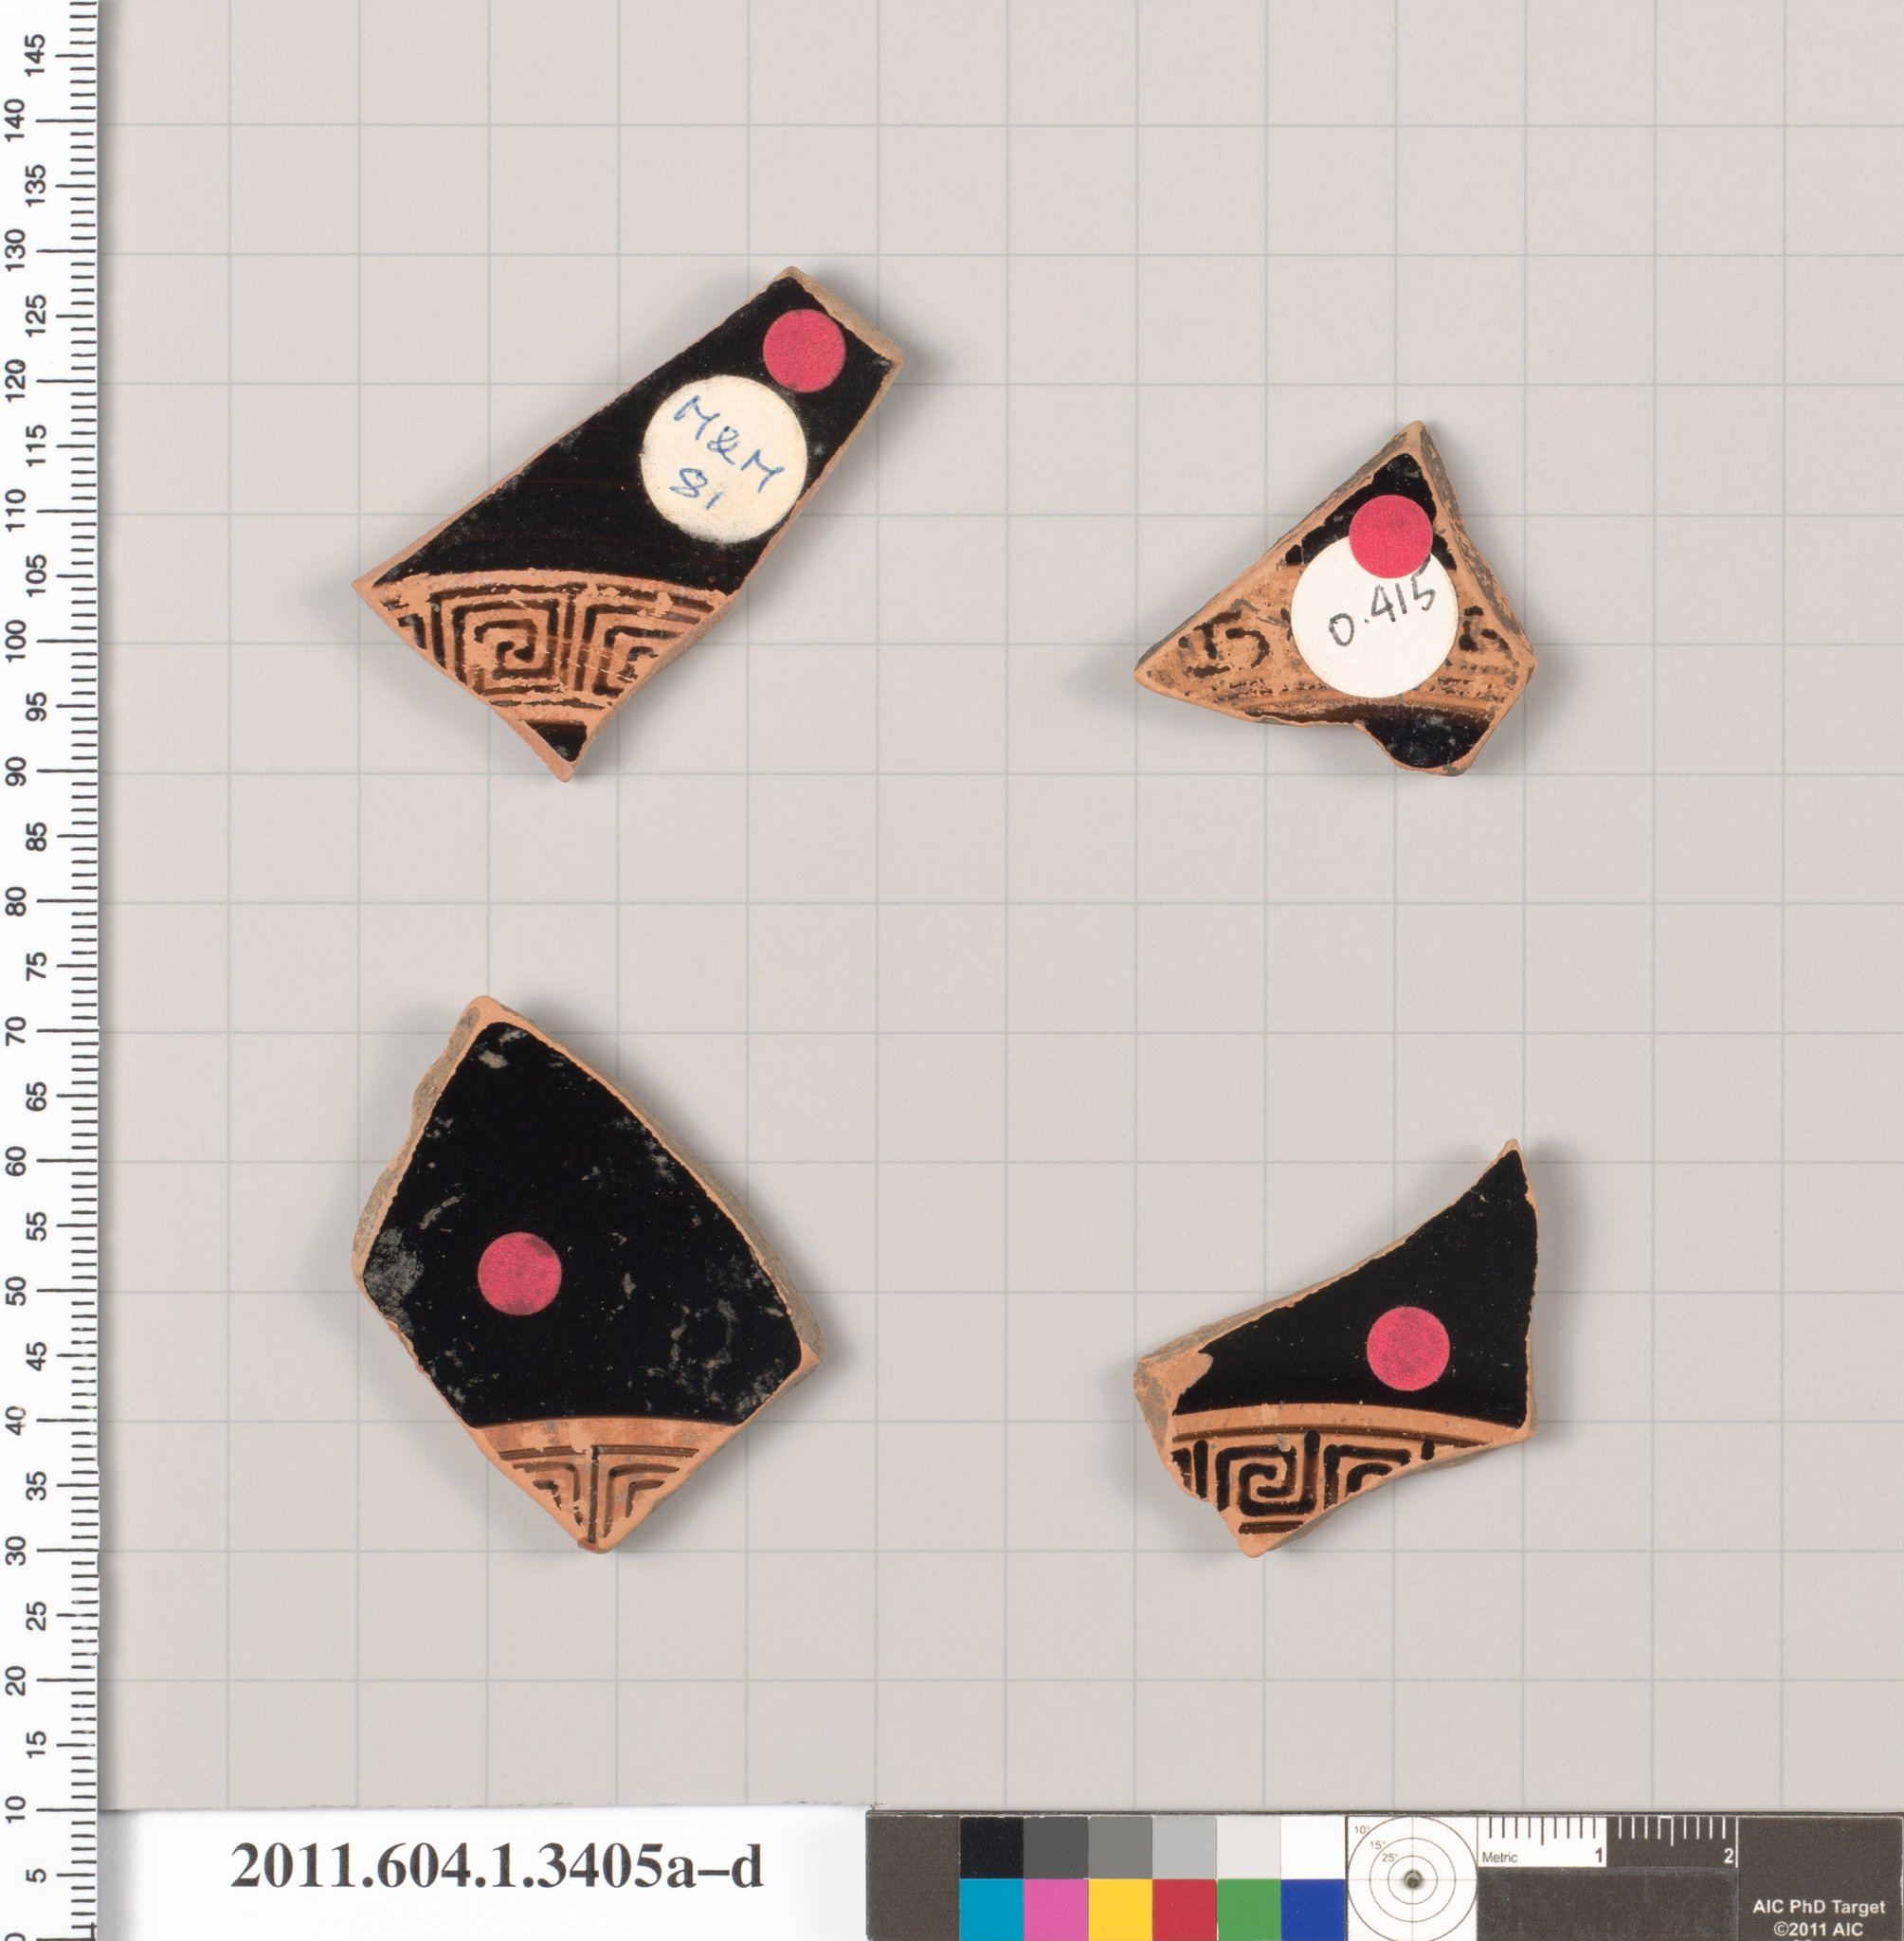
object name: kylix fragment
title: Terracotta fragments of kylikes (drinking cups)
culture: greek, attic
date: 510-470 BCE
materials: terracotta